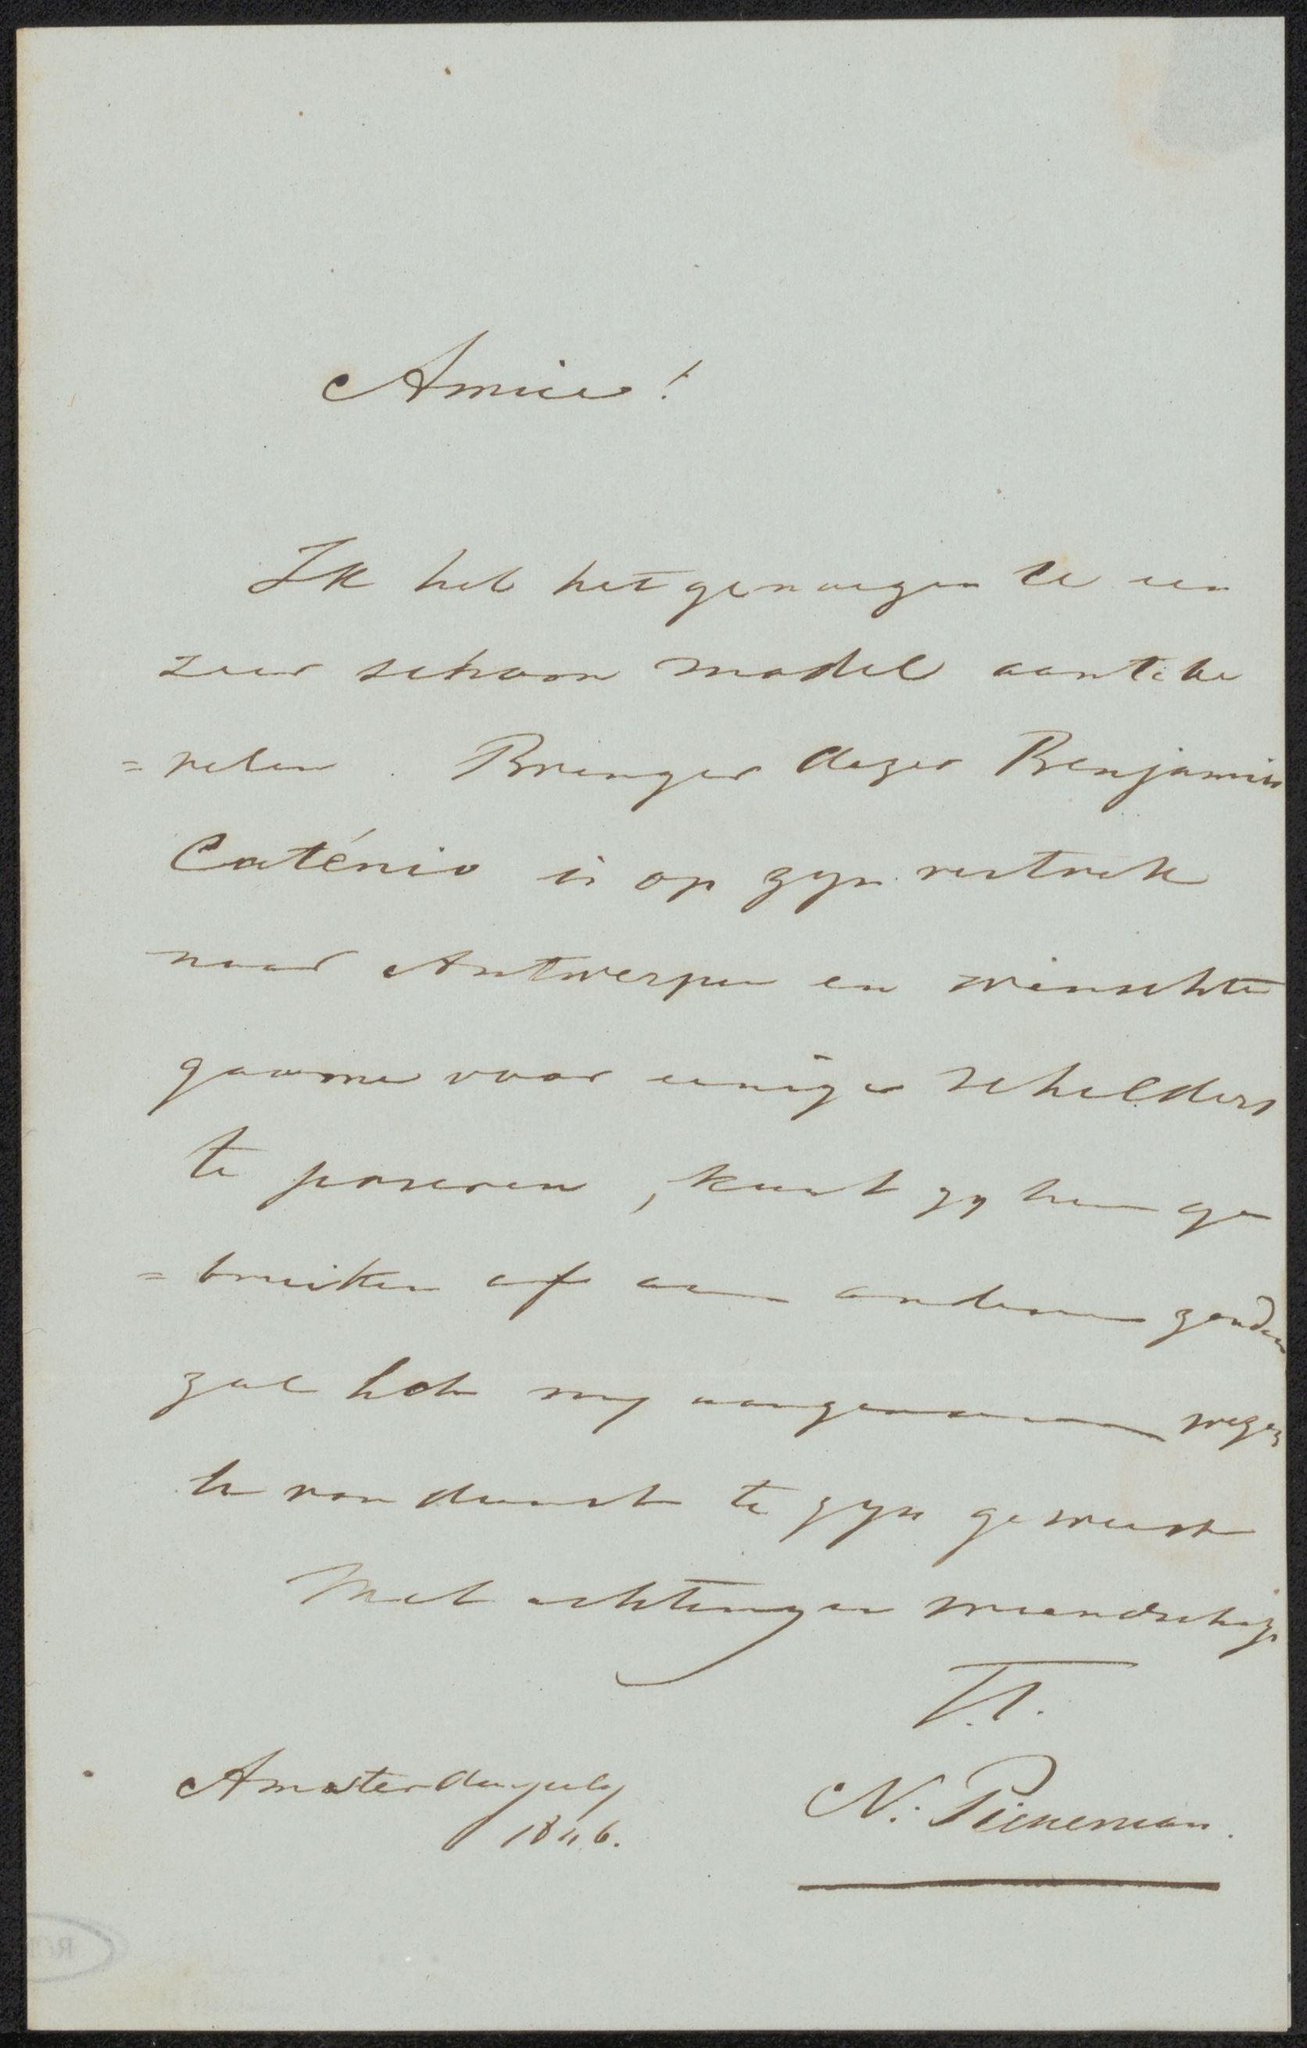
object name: letter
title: Brief aan Ary Johannes Lamme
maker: nicolaas pieneman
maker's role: draughtsman, painter, print maker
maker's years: 1809-1860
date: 1807-1846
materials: ink, paper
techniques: pen, writing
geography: amsterdam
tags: ary johannes lamme, artist's model, sitter, painting (including book-illumination, miniature-painting), antwerp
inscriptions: collector's mark: Lugt 2228